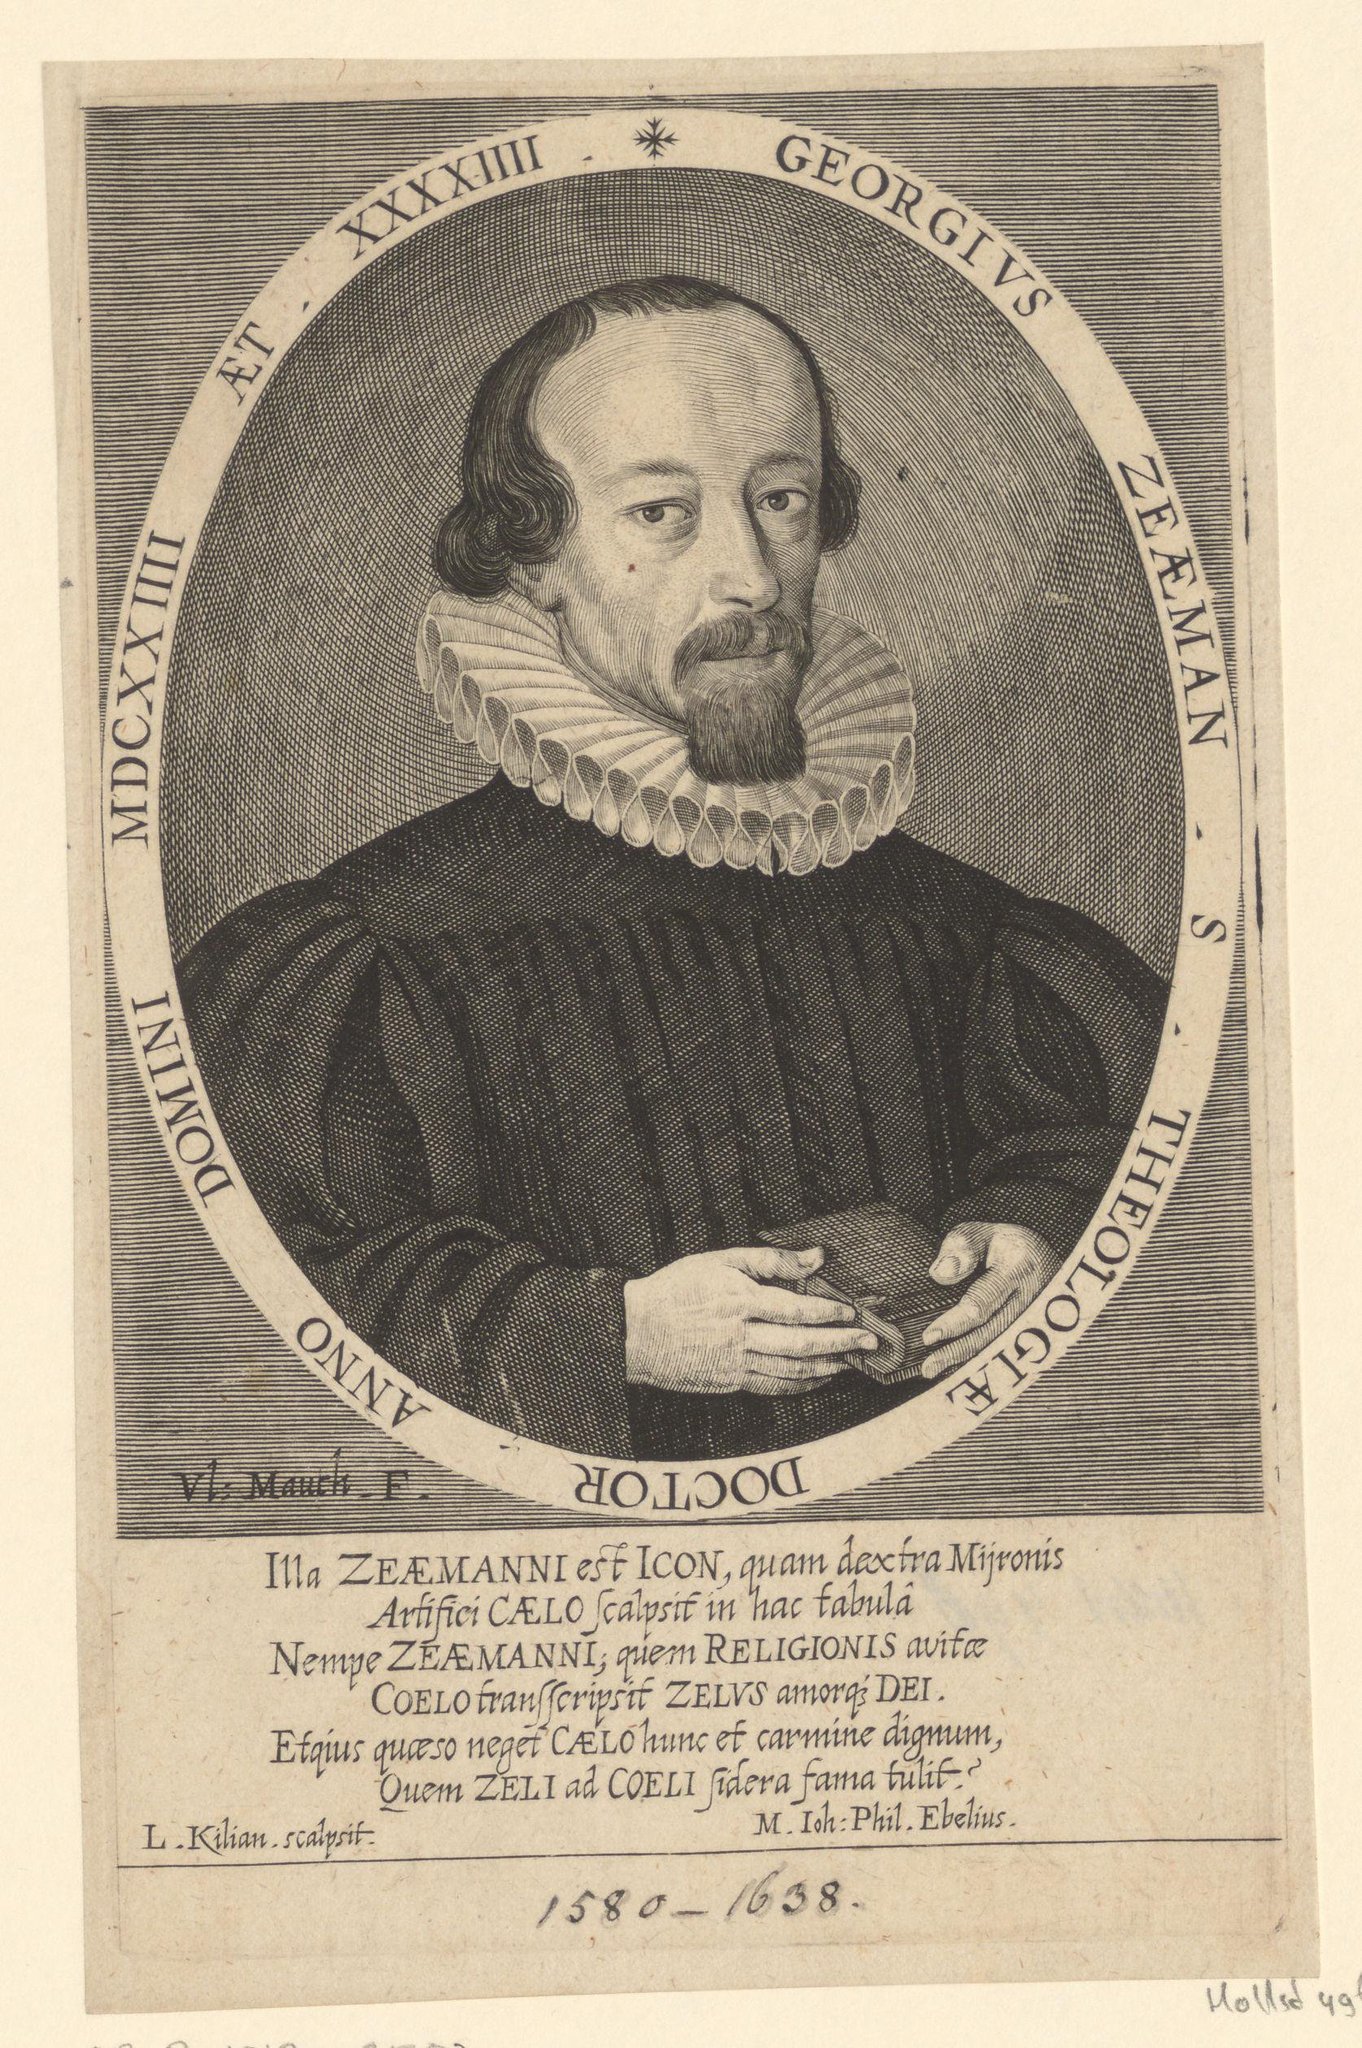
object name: print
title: Portret van Georg Zeämann op 38-jarige leeftijd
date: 1624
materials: paper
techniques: engraving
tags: theologian, further education (+ portrait of teacher, professor), historical persons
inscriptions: annotation: ‘1580-1636’, collector's mark: Lugt 2228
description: Tekst in het Latijn in de omlijsting en in de ondermarge.